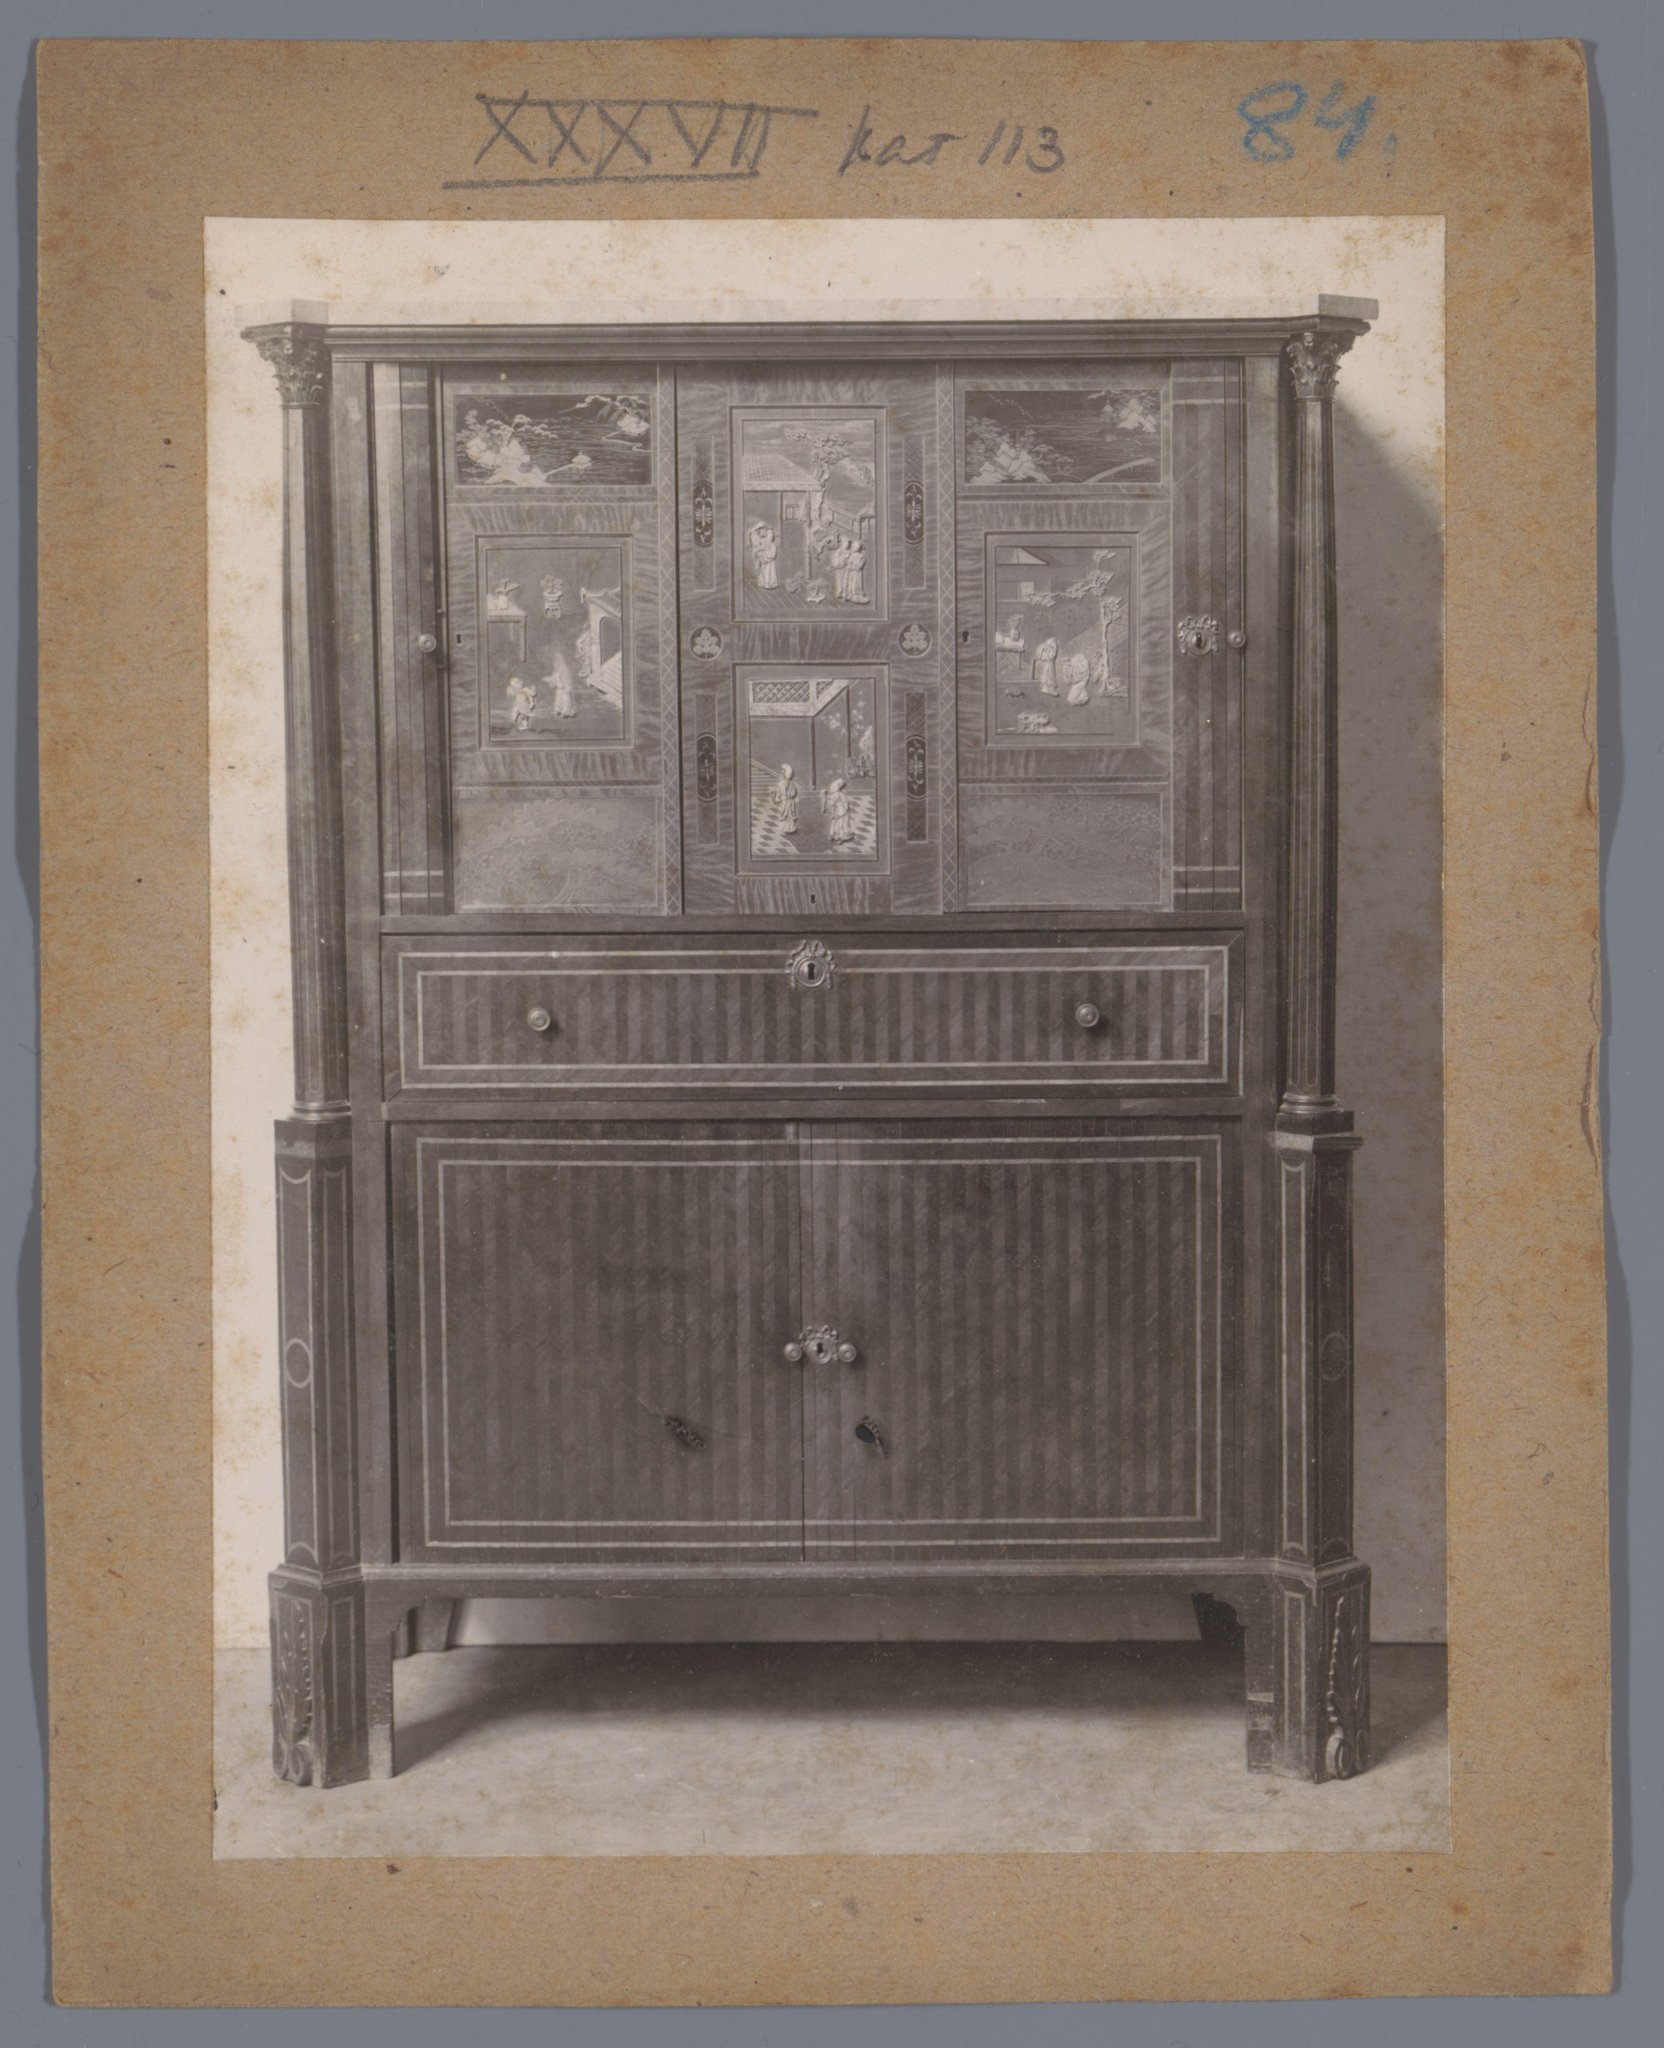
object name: photograph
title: Kast gedecoreerd met Oosterse voorstellingen (vermoedelijk) in het Rijksmuseum te Amsterdam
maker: Anonymous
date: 1875-1900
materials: photographic support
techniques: matte daylight collodion silver print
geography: amsterdam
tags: cupboard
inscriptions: collector's mark: ‘Instituut voor kunst-nijverheidsonderwijs Gabriël Metsustraat No. 16, Amsterdam’, collector's mark: ‘Kunstnijverheidschool Quellinus Amsterdam Frans Halsstraat 14.’, number: ‘XXXVII kat 113 84.’